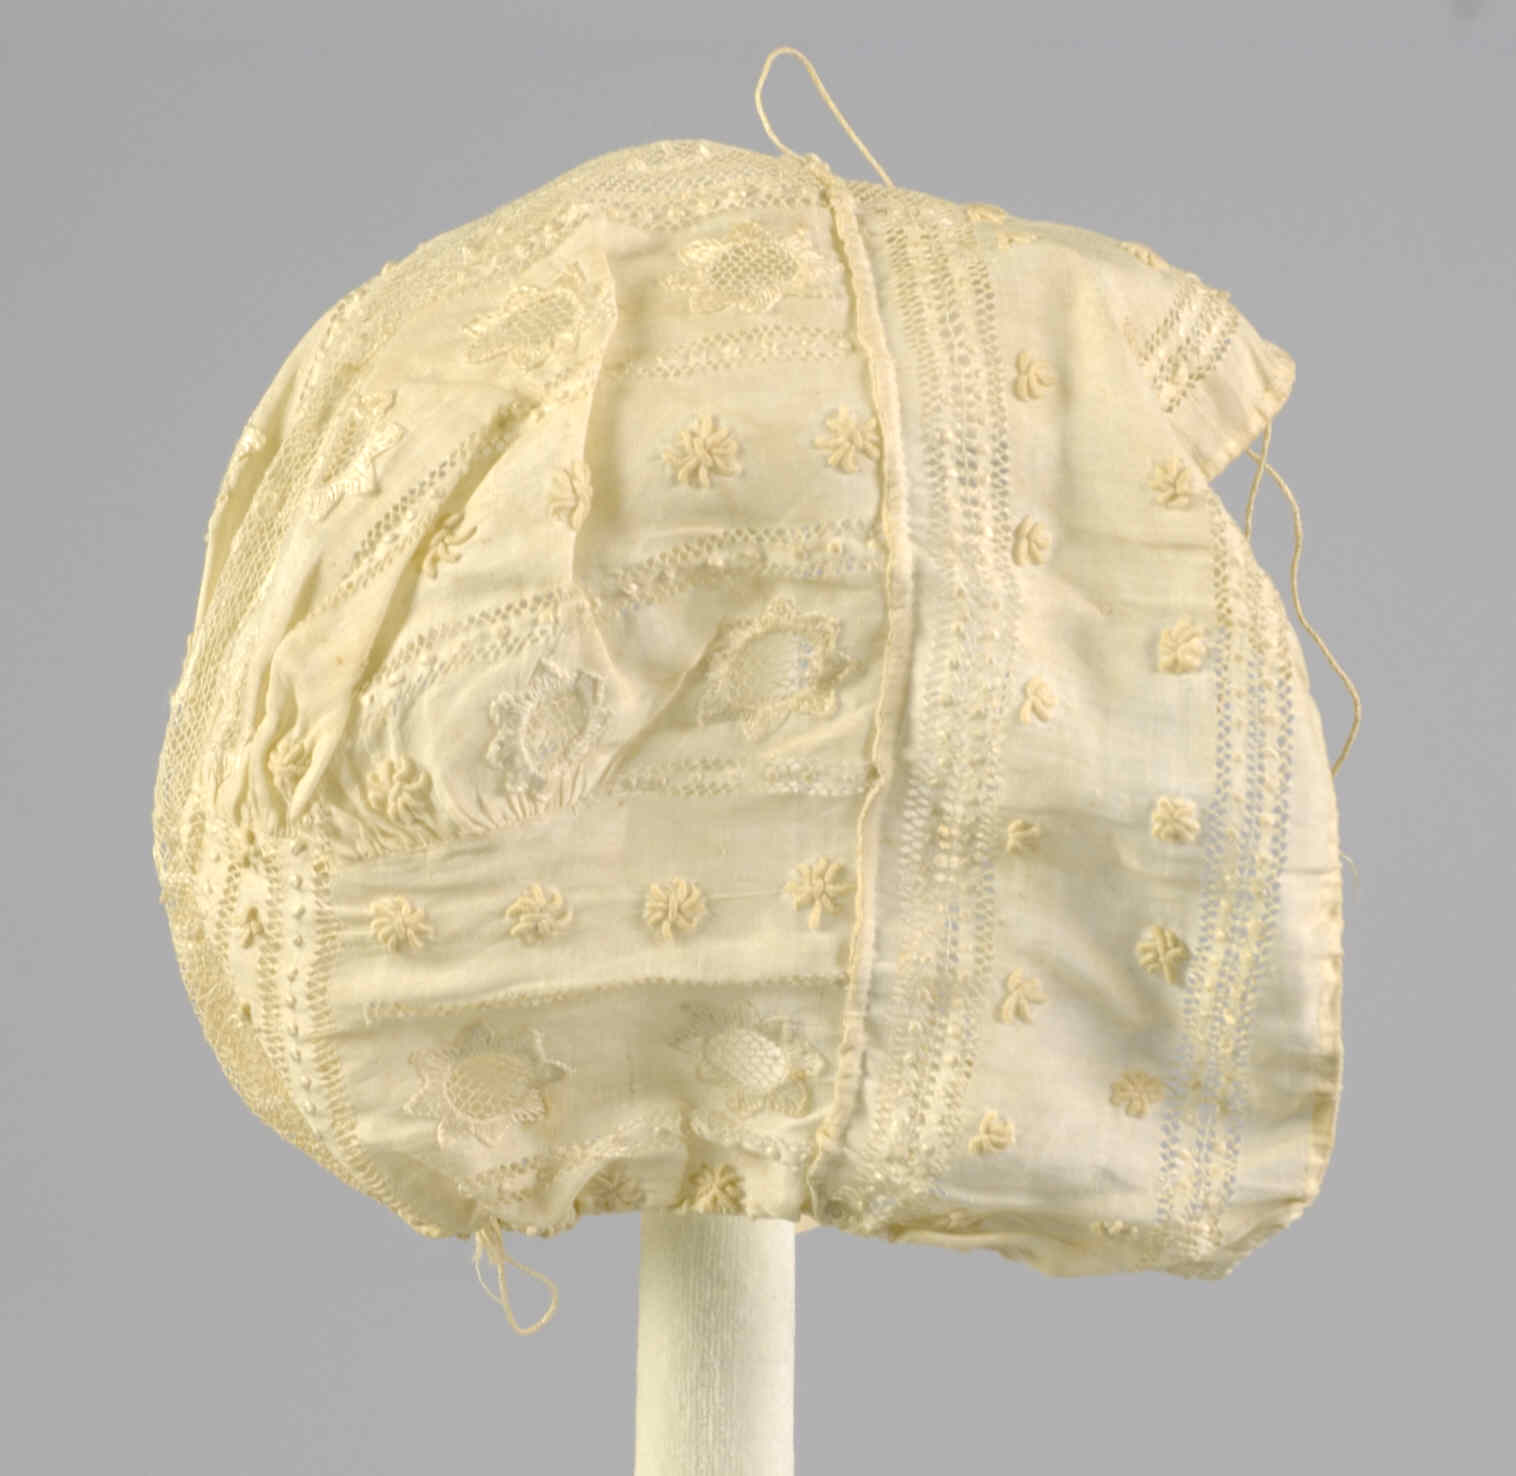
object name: cap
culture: american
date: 1840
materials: linen